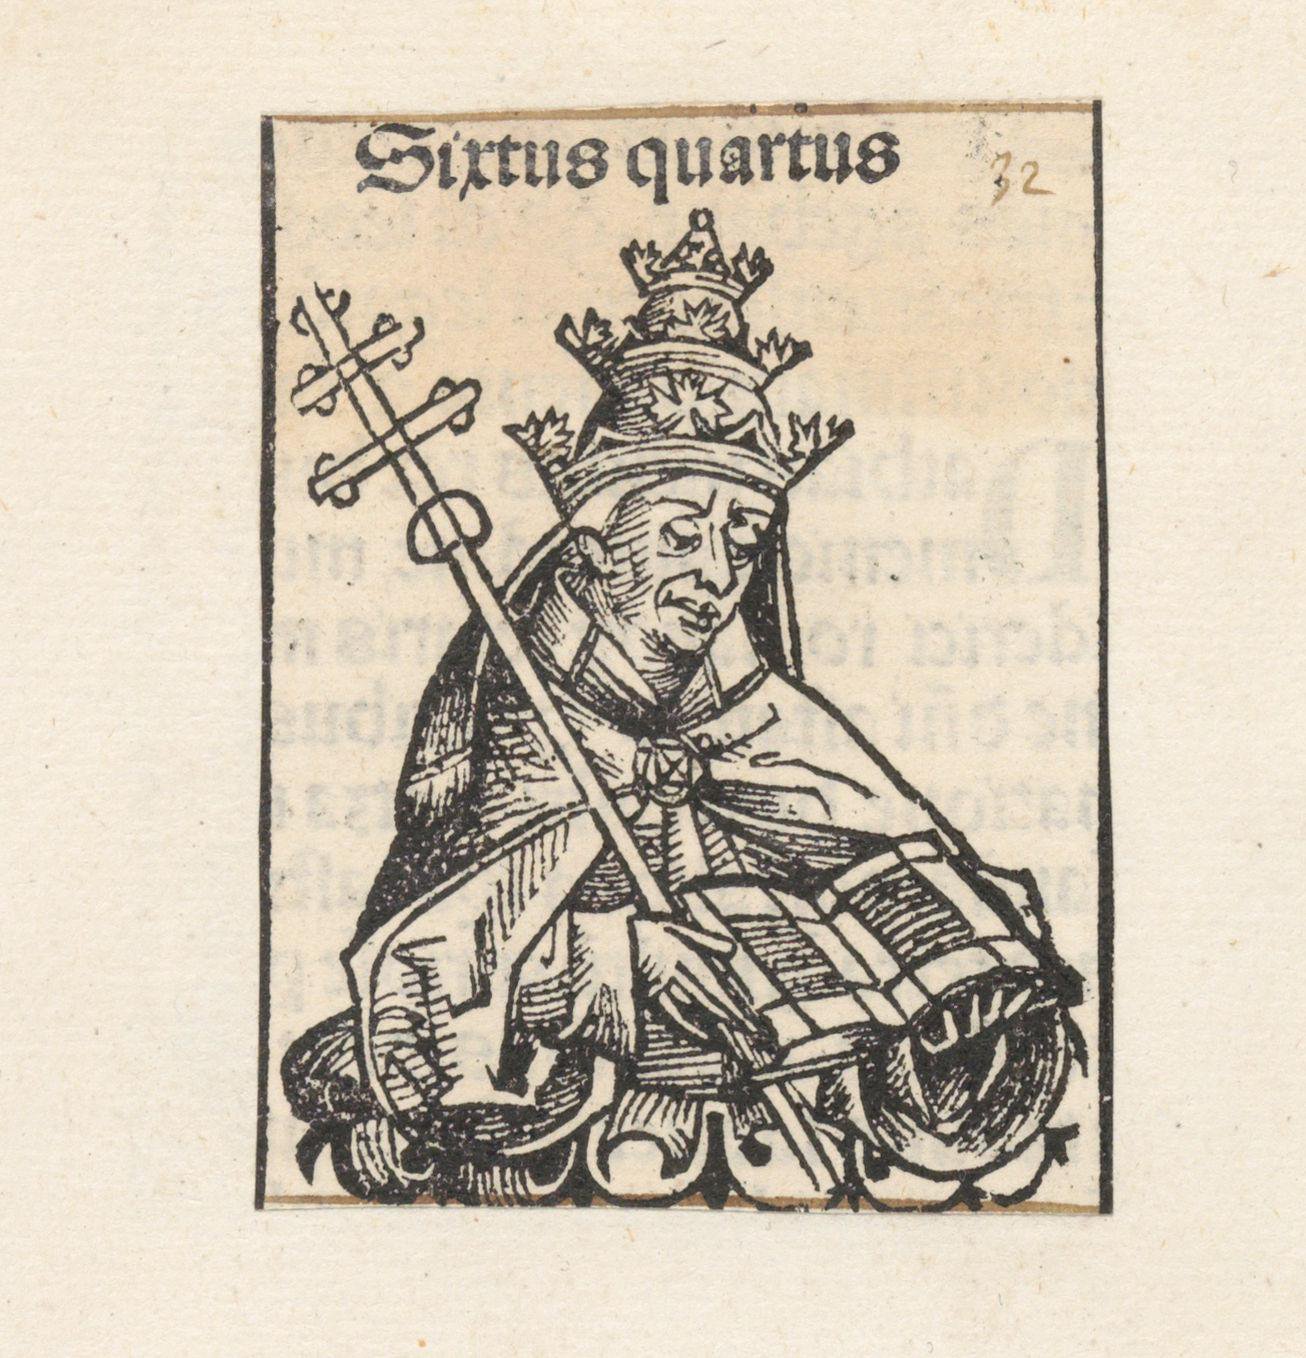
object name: album leaf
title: Sixtus quartus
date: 1493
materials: paper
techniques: letterpress printing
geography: nuremberg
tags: rome, pope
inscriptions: inscription: ‘32’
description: Een bloemkelk met een paus. Hij draagt een tiara en heeft een opengeslagen bijbel en een staf met een dubbel kruis in zijn handen. De voorstelling is onderdeel van de opeenvolging pausen in de Liber Chronicarum. De tekst identificeert de man als Sixtus IV. De prent maakt deel uit van een album.